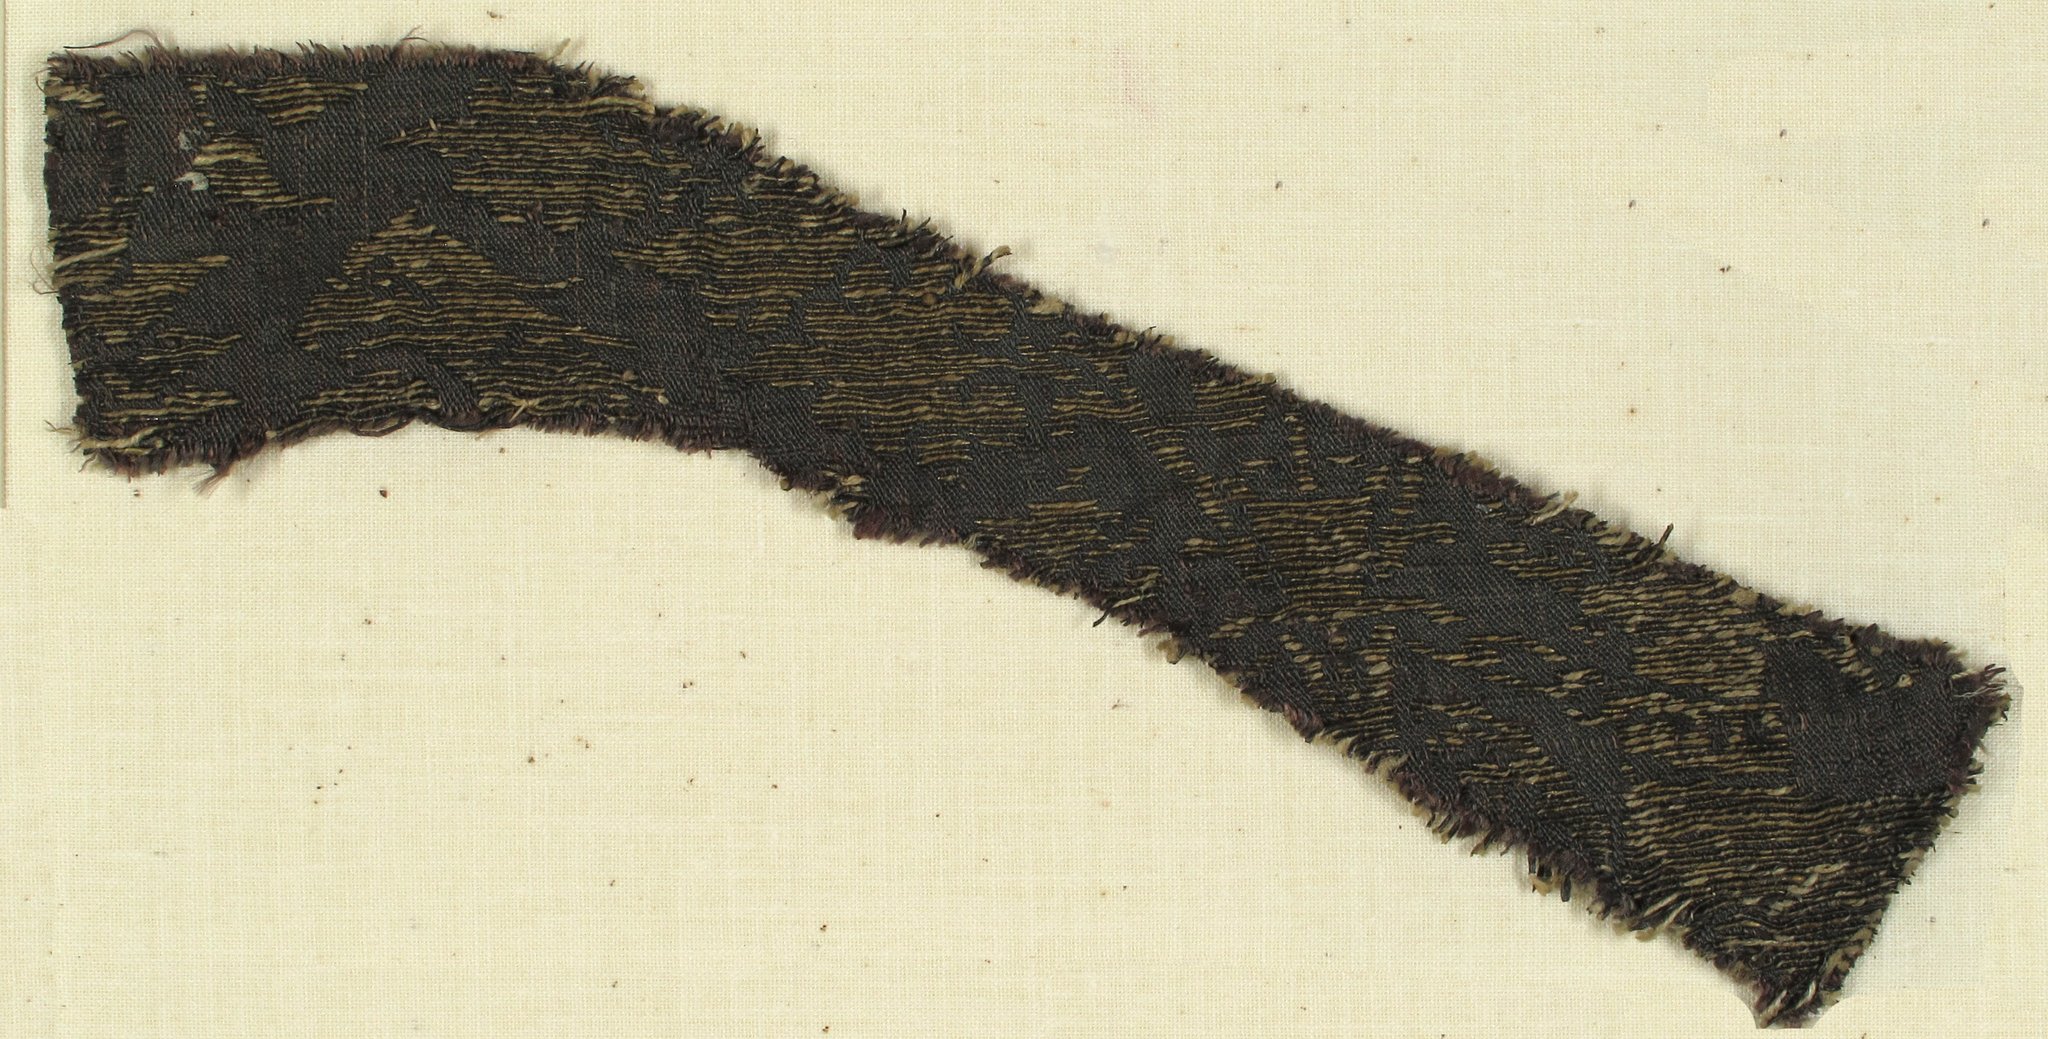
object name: textile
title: Textile with Foliated Ornament and Eagle's Head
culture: italian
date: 1301-1400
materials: metal thread, silk